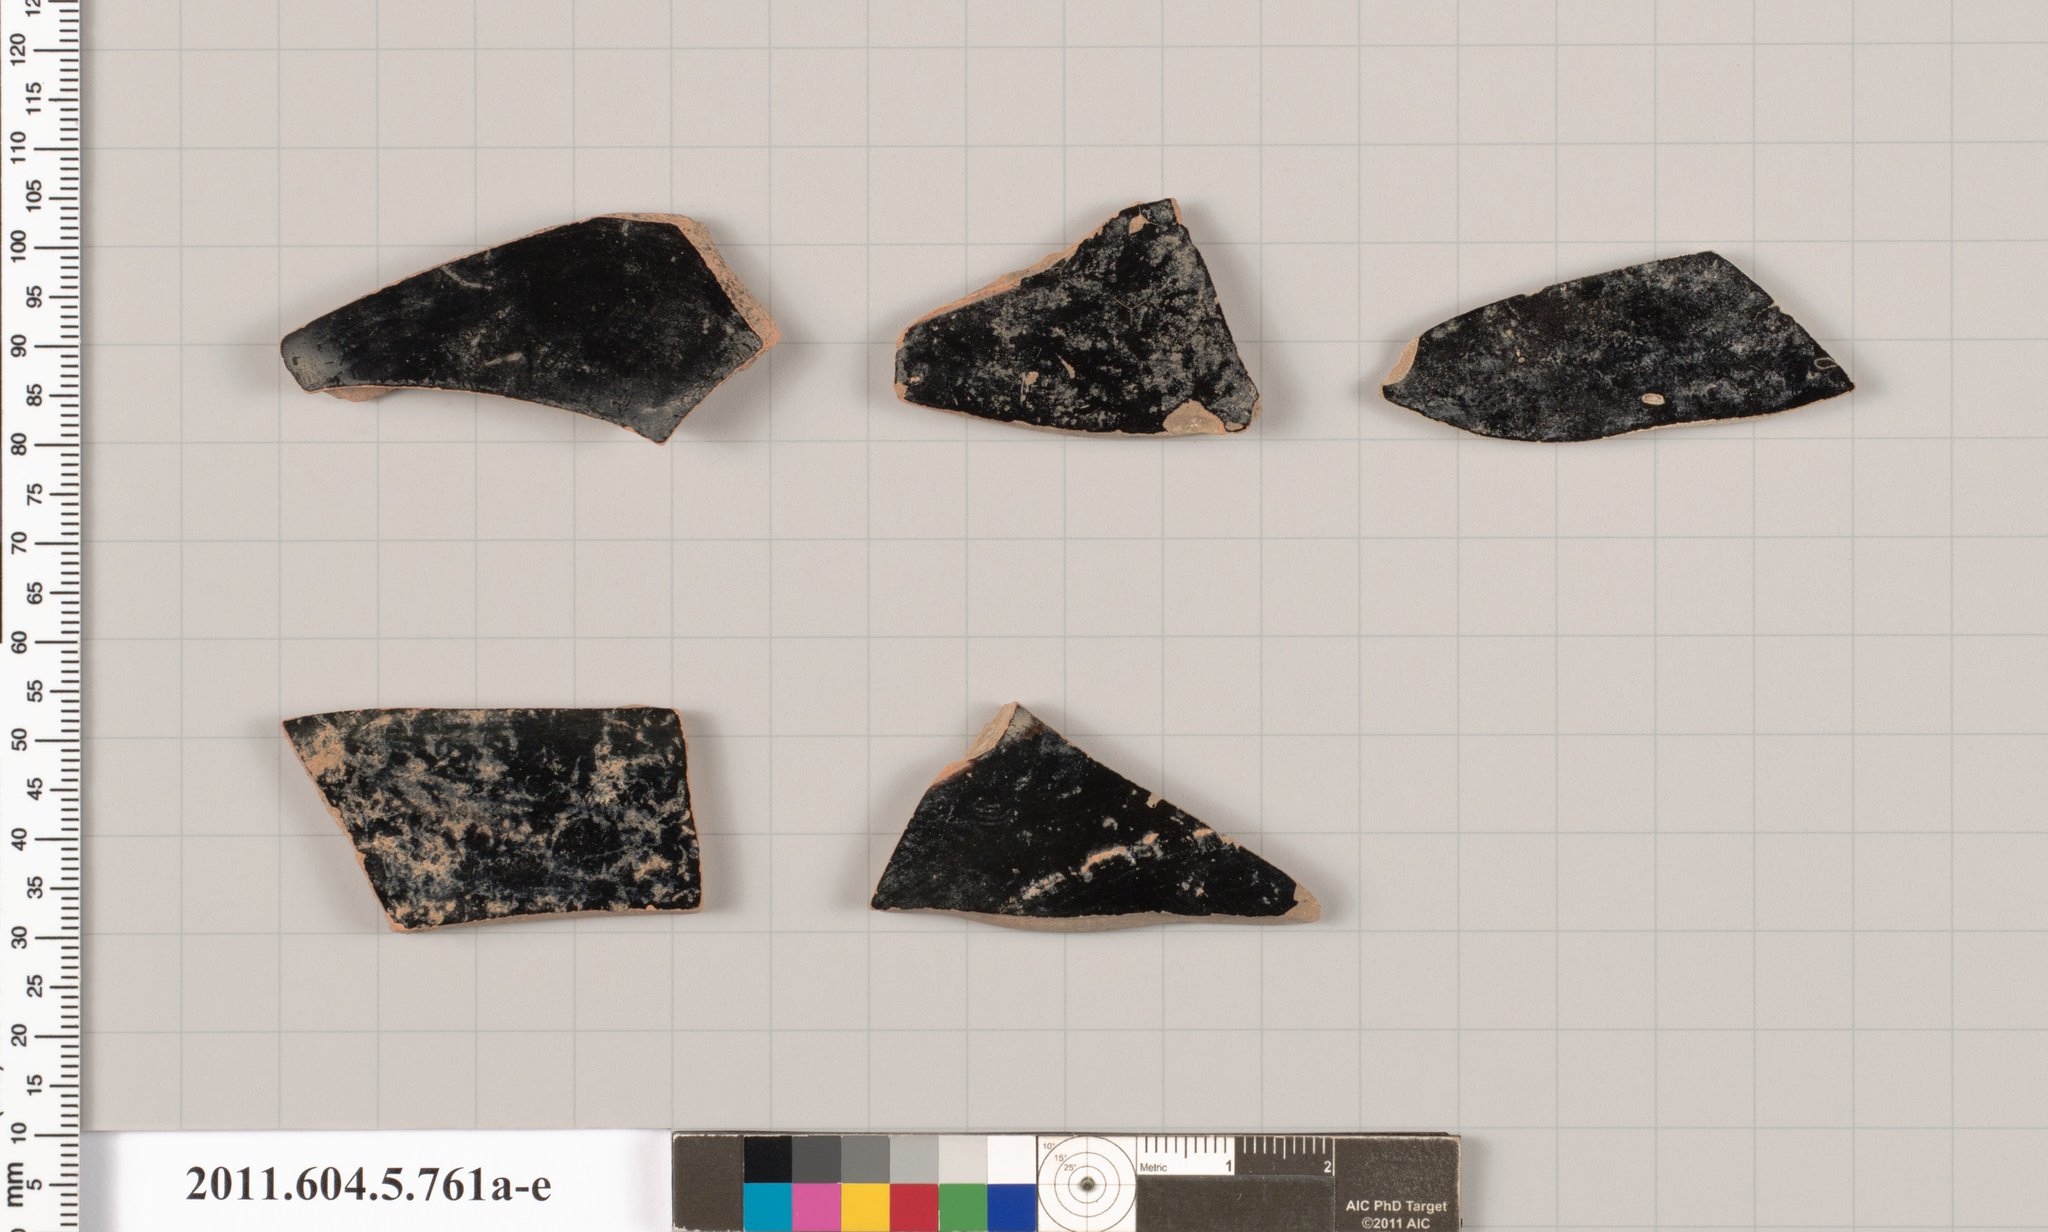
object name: kylix fragment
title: Terracotta fragments of kylikes (drinking cups)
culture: greek, attic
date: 600-401 BCE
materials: terracotta